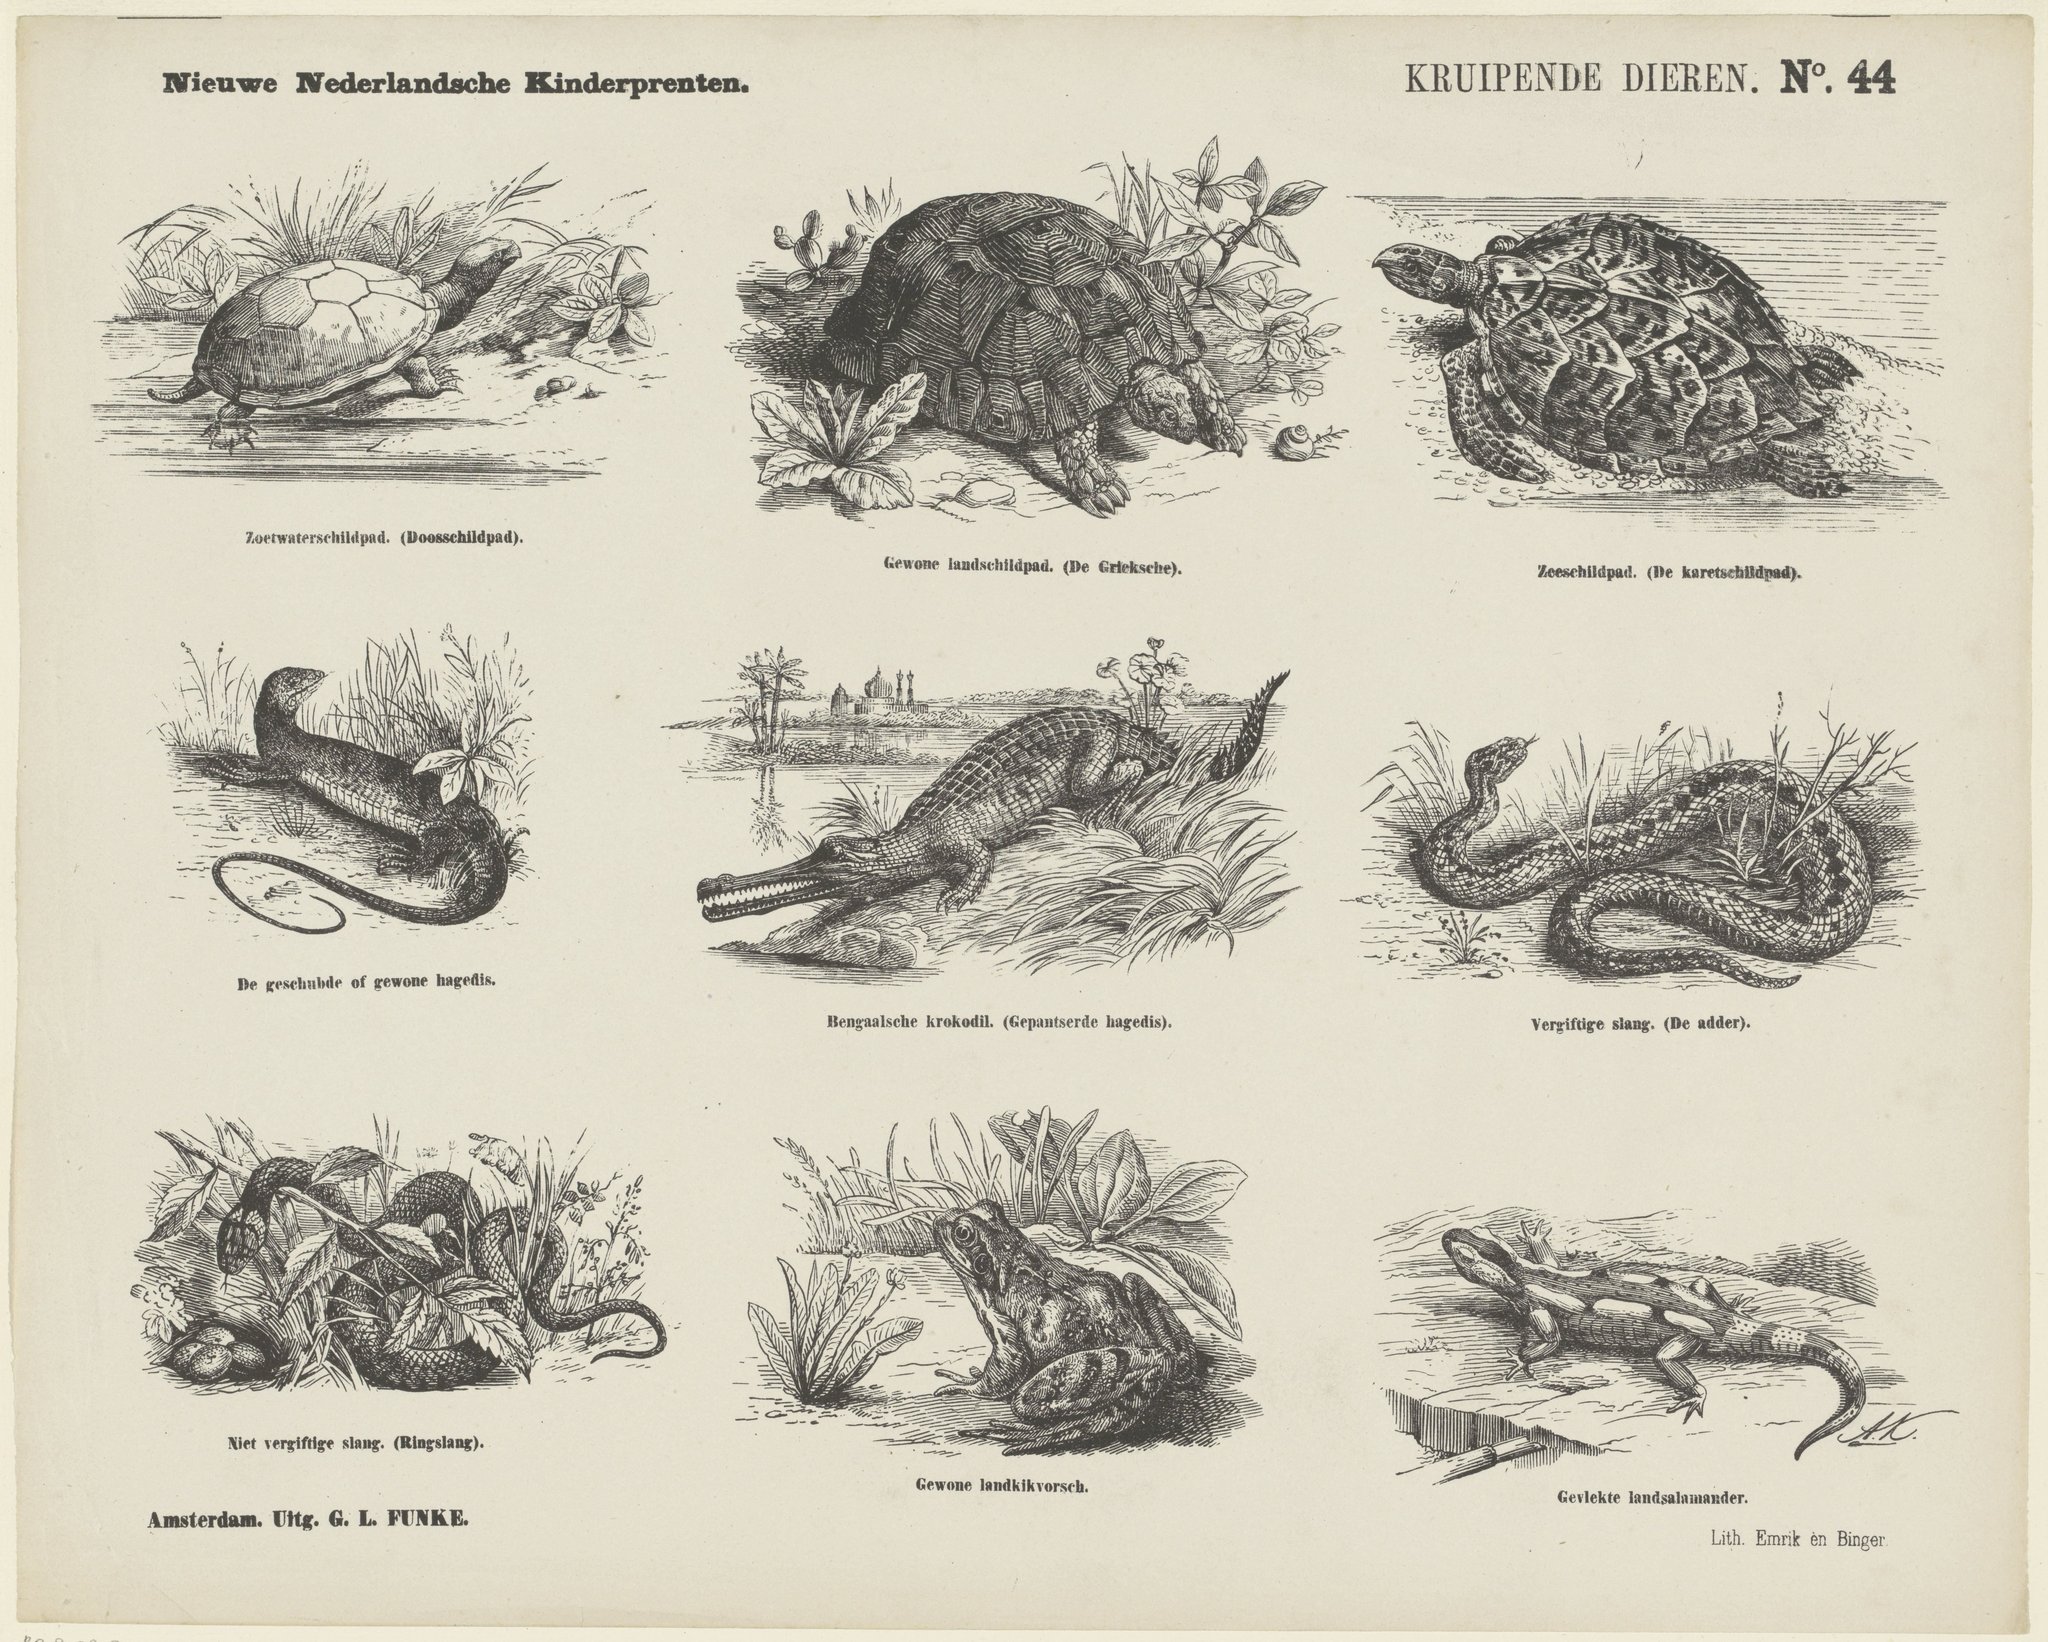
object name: print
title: Kruipende dieren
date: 1865-1875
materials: paper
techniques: letterpress printing, lithograph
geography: amsterdam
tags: tailless amphibians: frog, snakes, crocodiles: crocodile, reptiles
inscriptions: collector's mark: Lugt 2760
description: Blad met 9 voorstellingen van reptielen en amfibieën, onder andere schildpadden, slangen en een kikker. Onder elke afbeelding een onderschrift. Genummerd rechtsboven: No. 44.